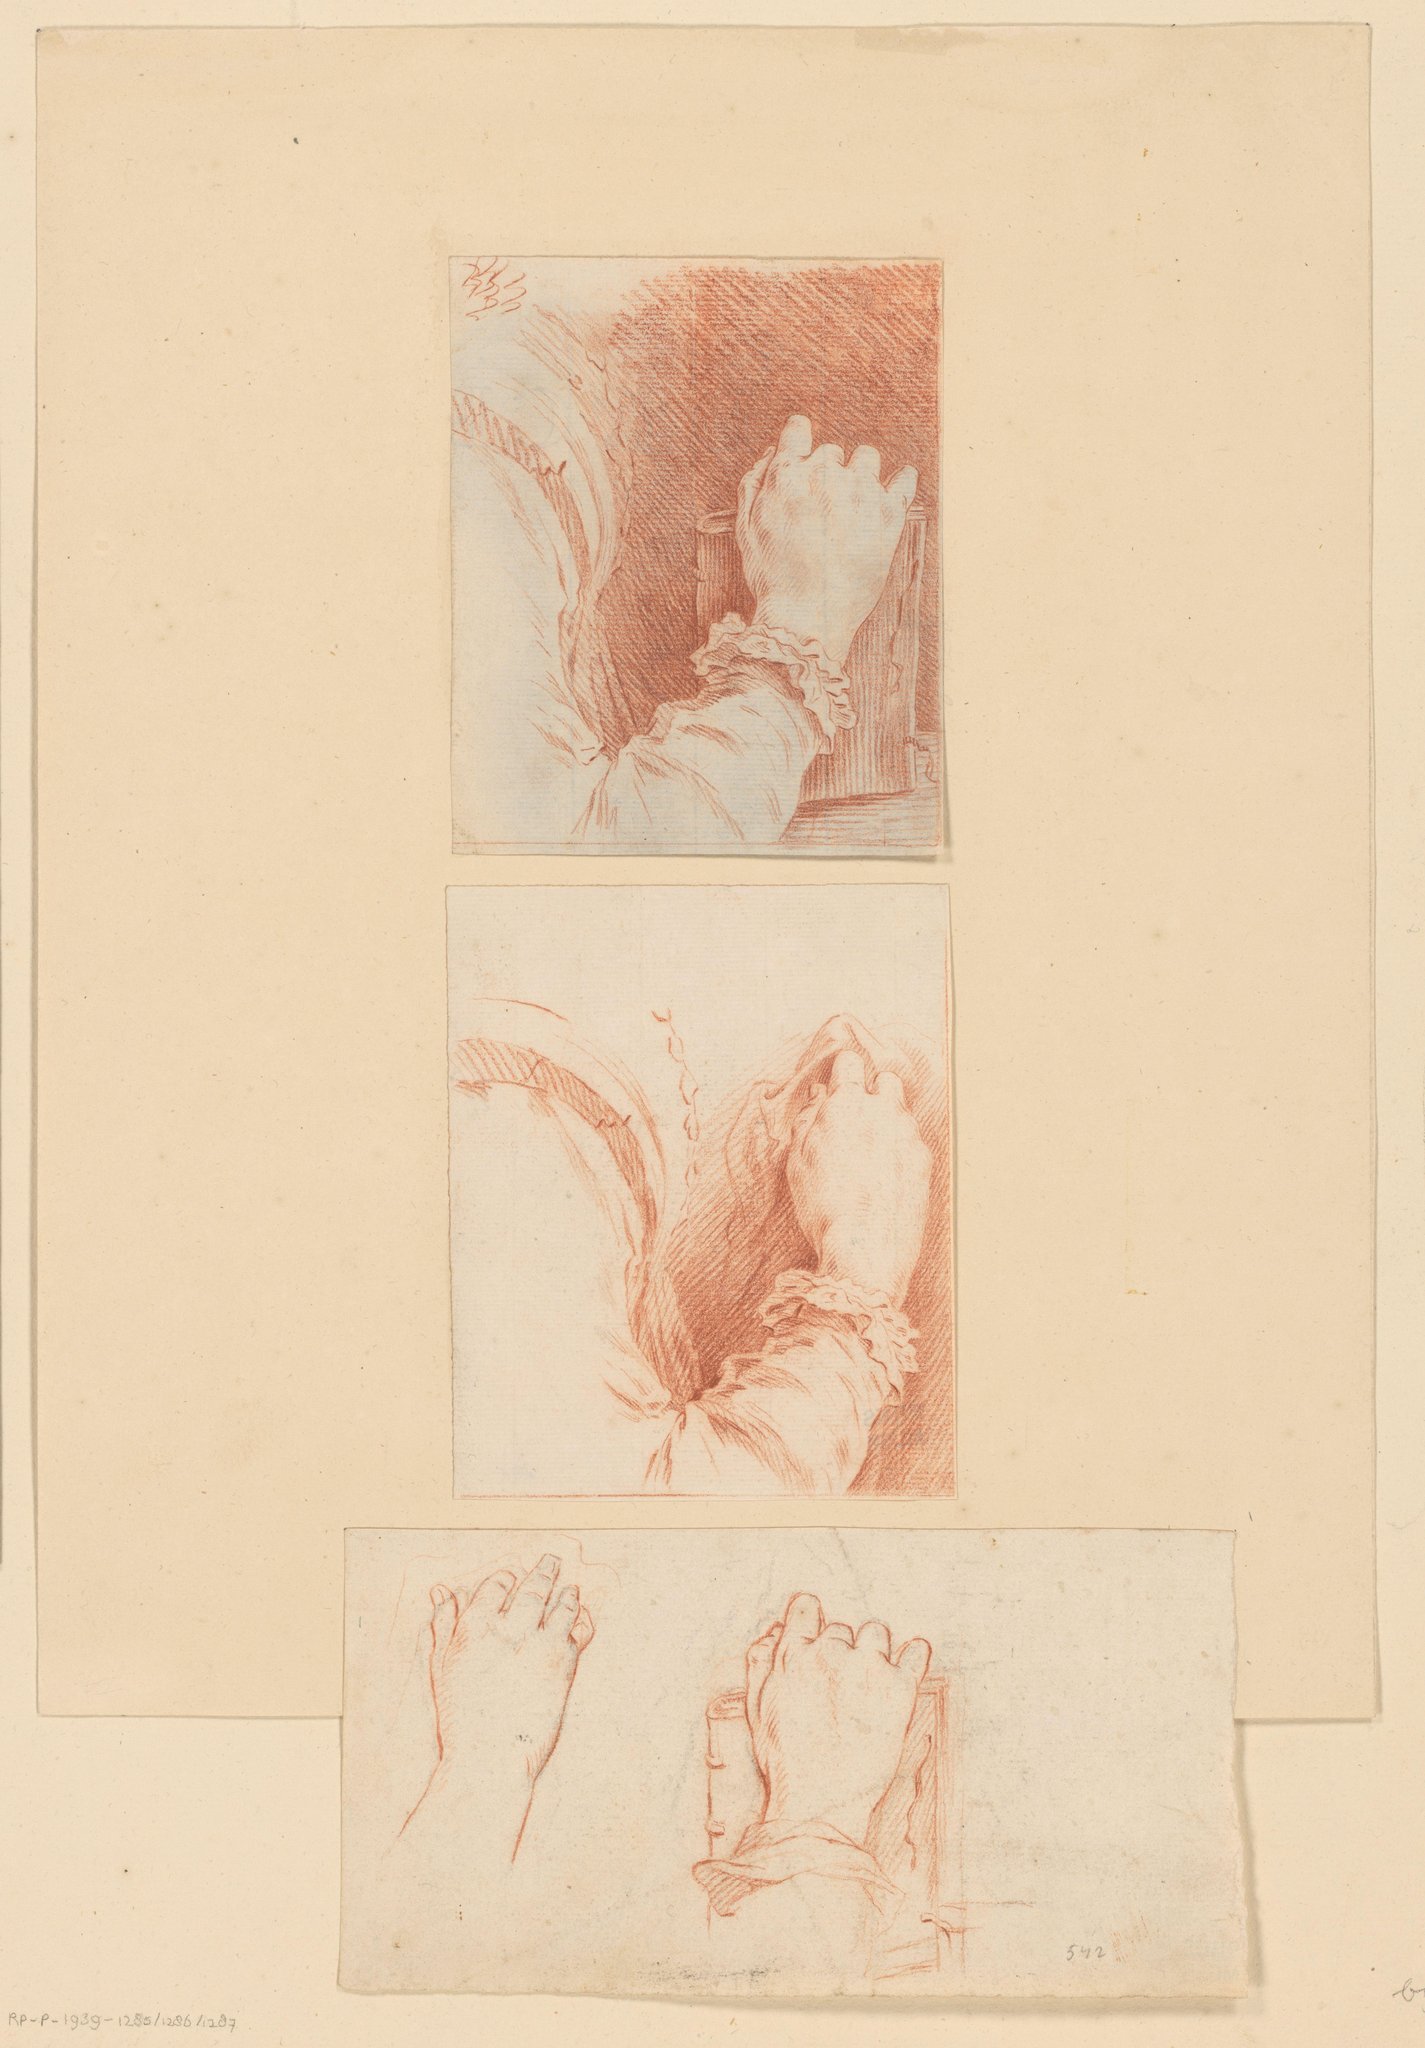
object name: drawing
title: Hand met een zakdoek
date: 1770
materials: chalk, paper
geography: amsterdam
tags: imposition of hands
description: De tekening ligt los in een album, zie blad 18.